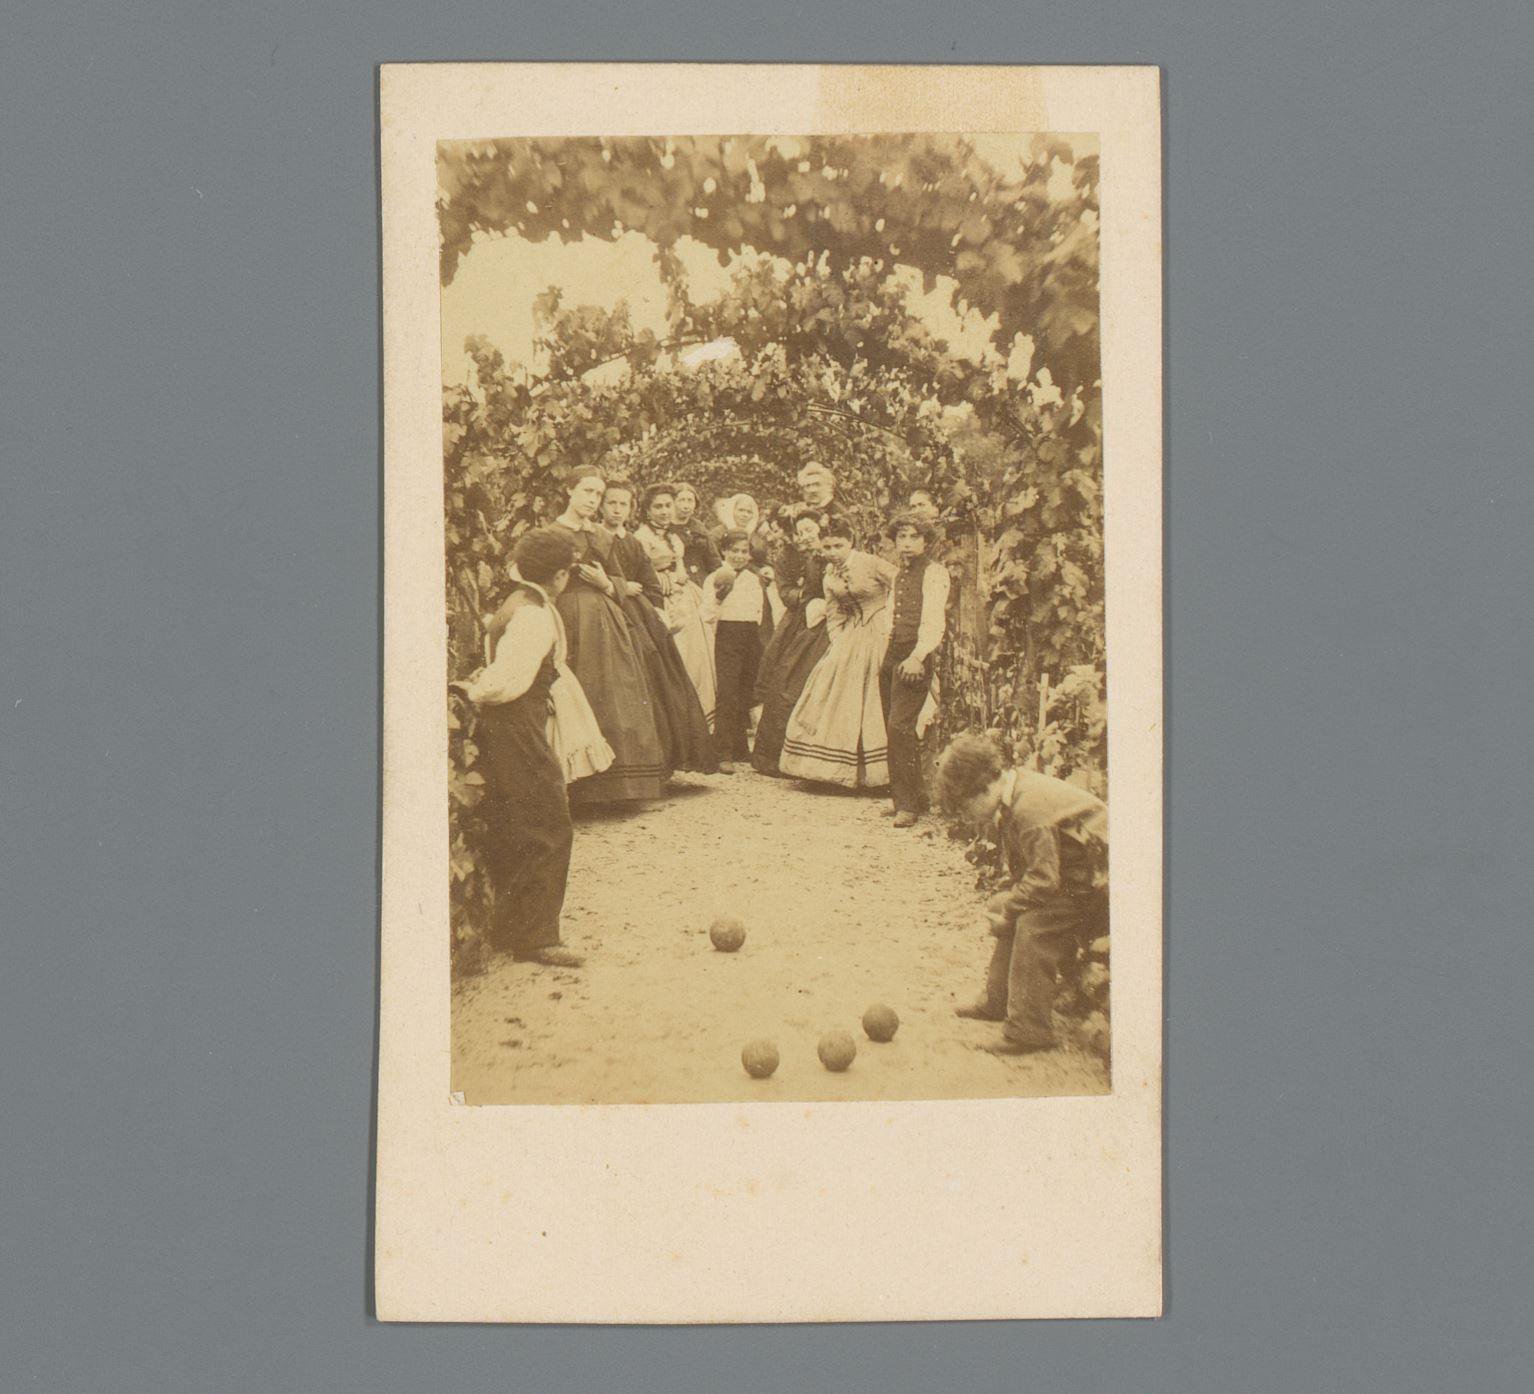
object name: photograph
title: Gezelschap speelt jeu de boules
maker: Anonymous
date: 1865-1870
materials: cardboard, paper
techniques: albumen print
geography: paris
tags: 'jeu de boules', paris